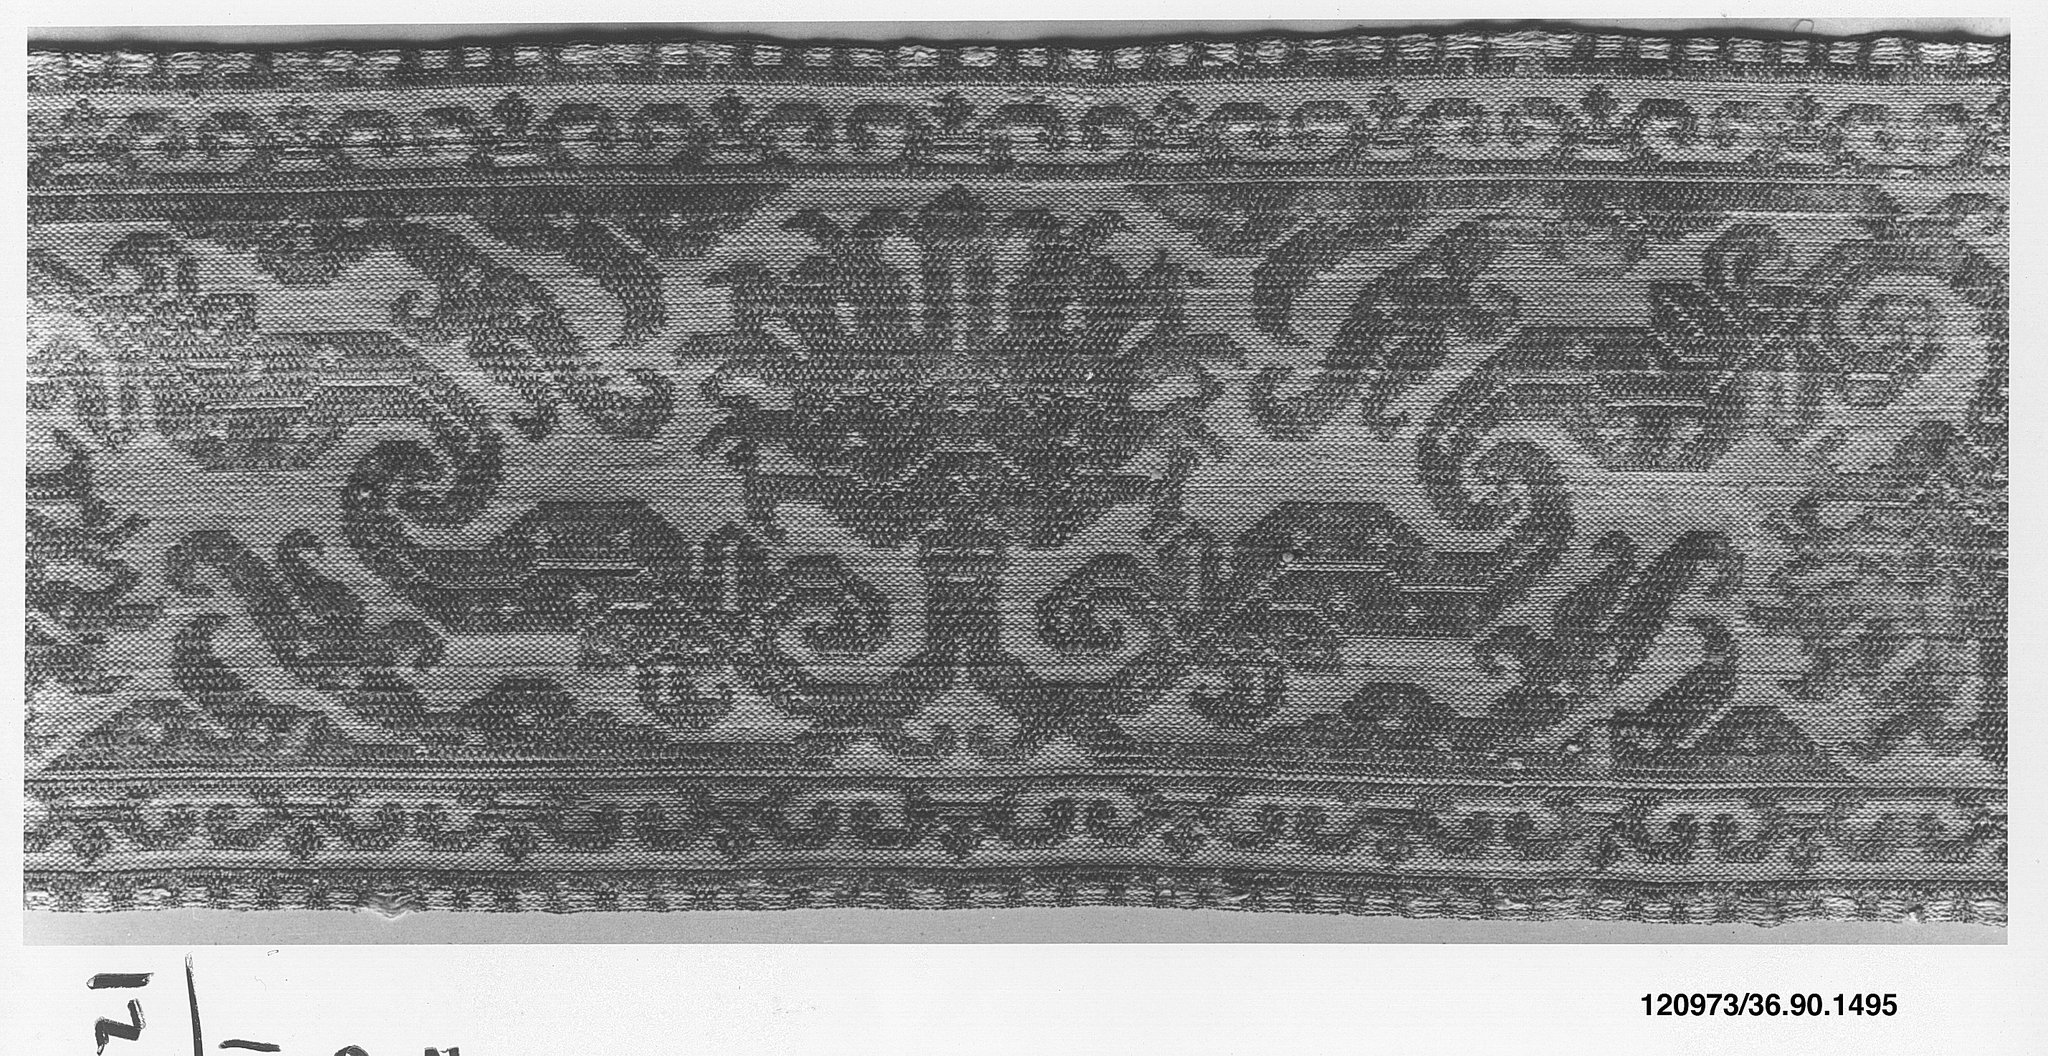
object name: piece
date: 1501-1700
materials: cotton, silk